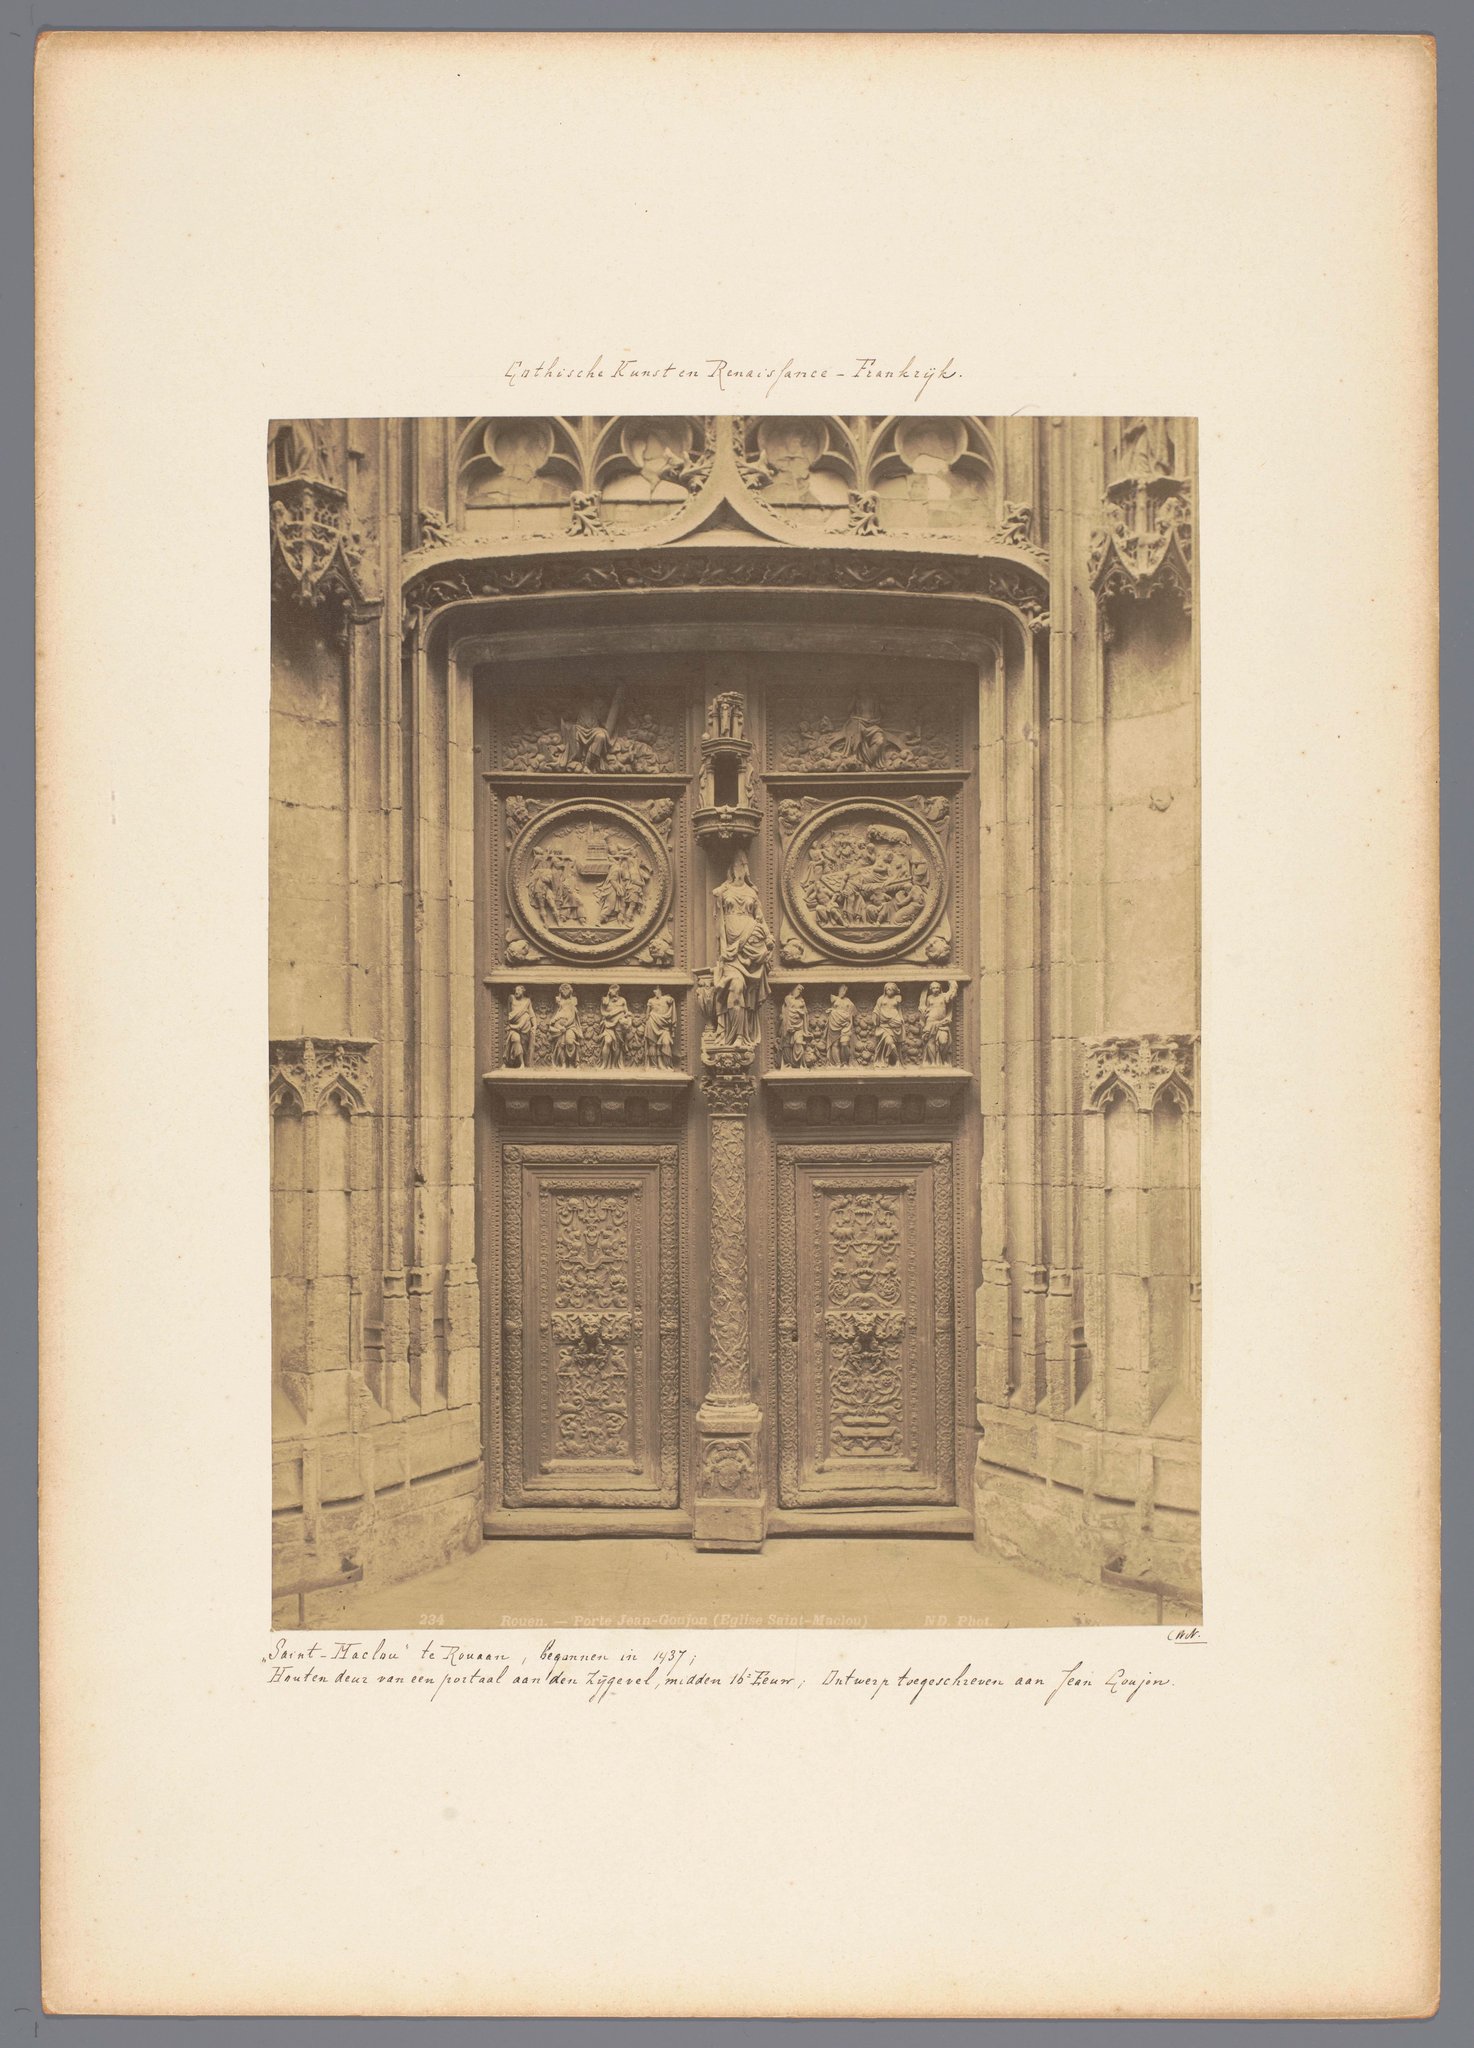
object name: photograph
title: Rouen. - Porte Jean-Goujon (Eglise Saint-Maclou)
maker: étienne neurdein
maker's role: publisher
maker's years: 1832-1918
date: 1875-1900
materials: cardboard, photographic support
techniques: albumen print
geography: church of saint-maclou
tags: parts of church exterior and annexes: portal, door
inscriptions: inscription: ‘Gothische Kunst en Renaissance - Frankrijk.’, collector's mark: ‘INSTITUUT VOOR KUNST-NIJVERHEIDSONDERWIJS GABRIËL METSUSTRAAT No. 16 AMSTERDAM’, number: ‘234’, inscription: ‘CWN.’, collector's mark: ‘KUNSTNIJVERHEIDSCHOOL QUELLINUS AMSTERDAM FRANS HALSSTRAAT 14.’